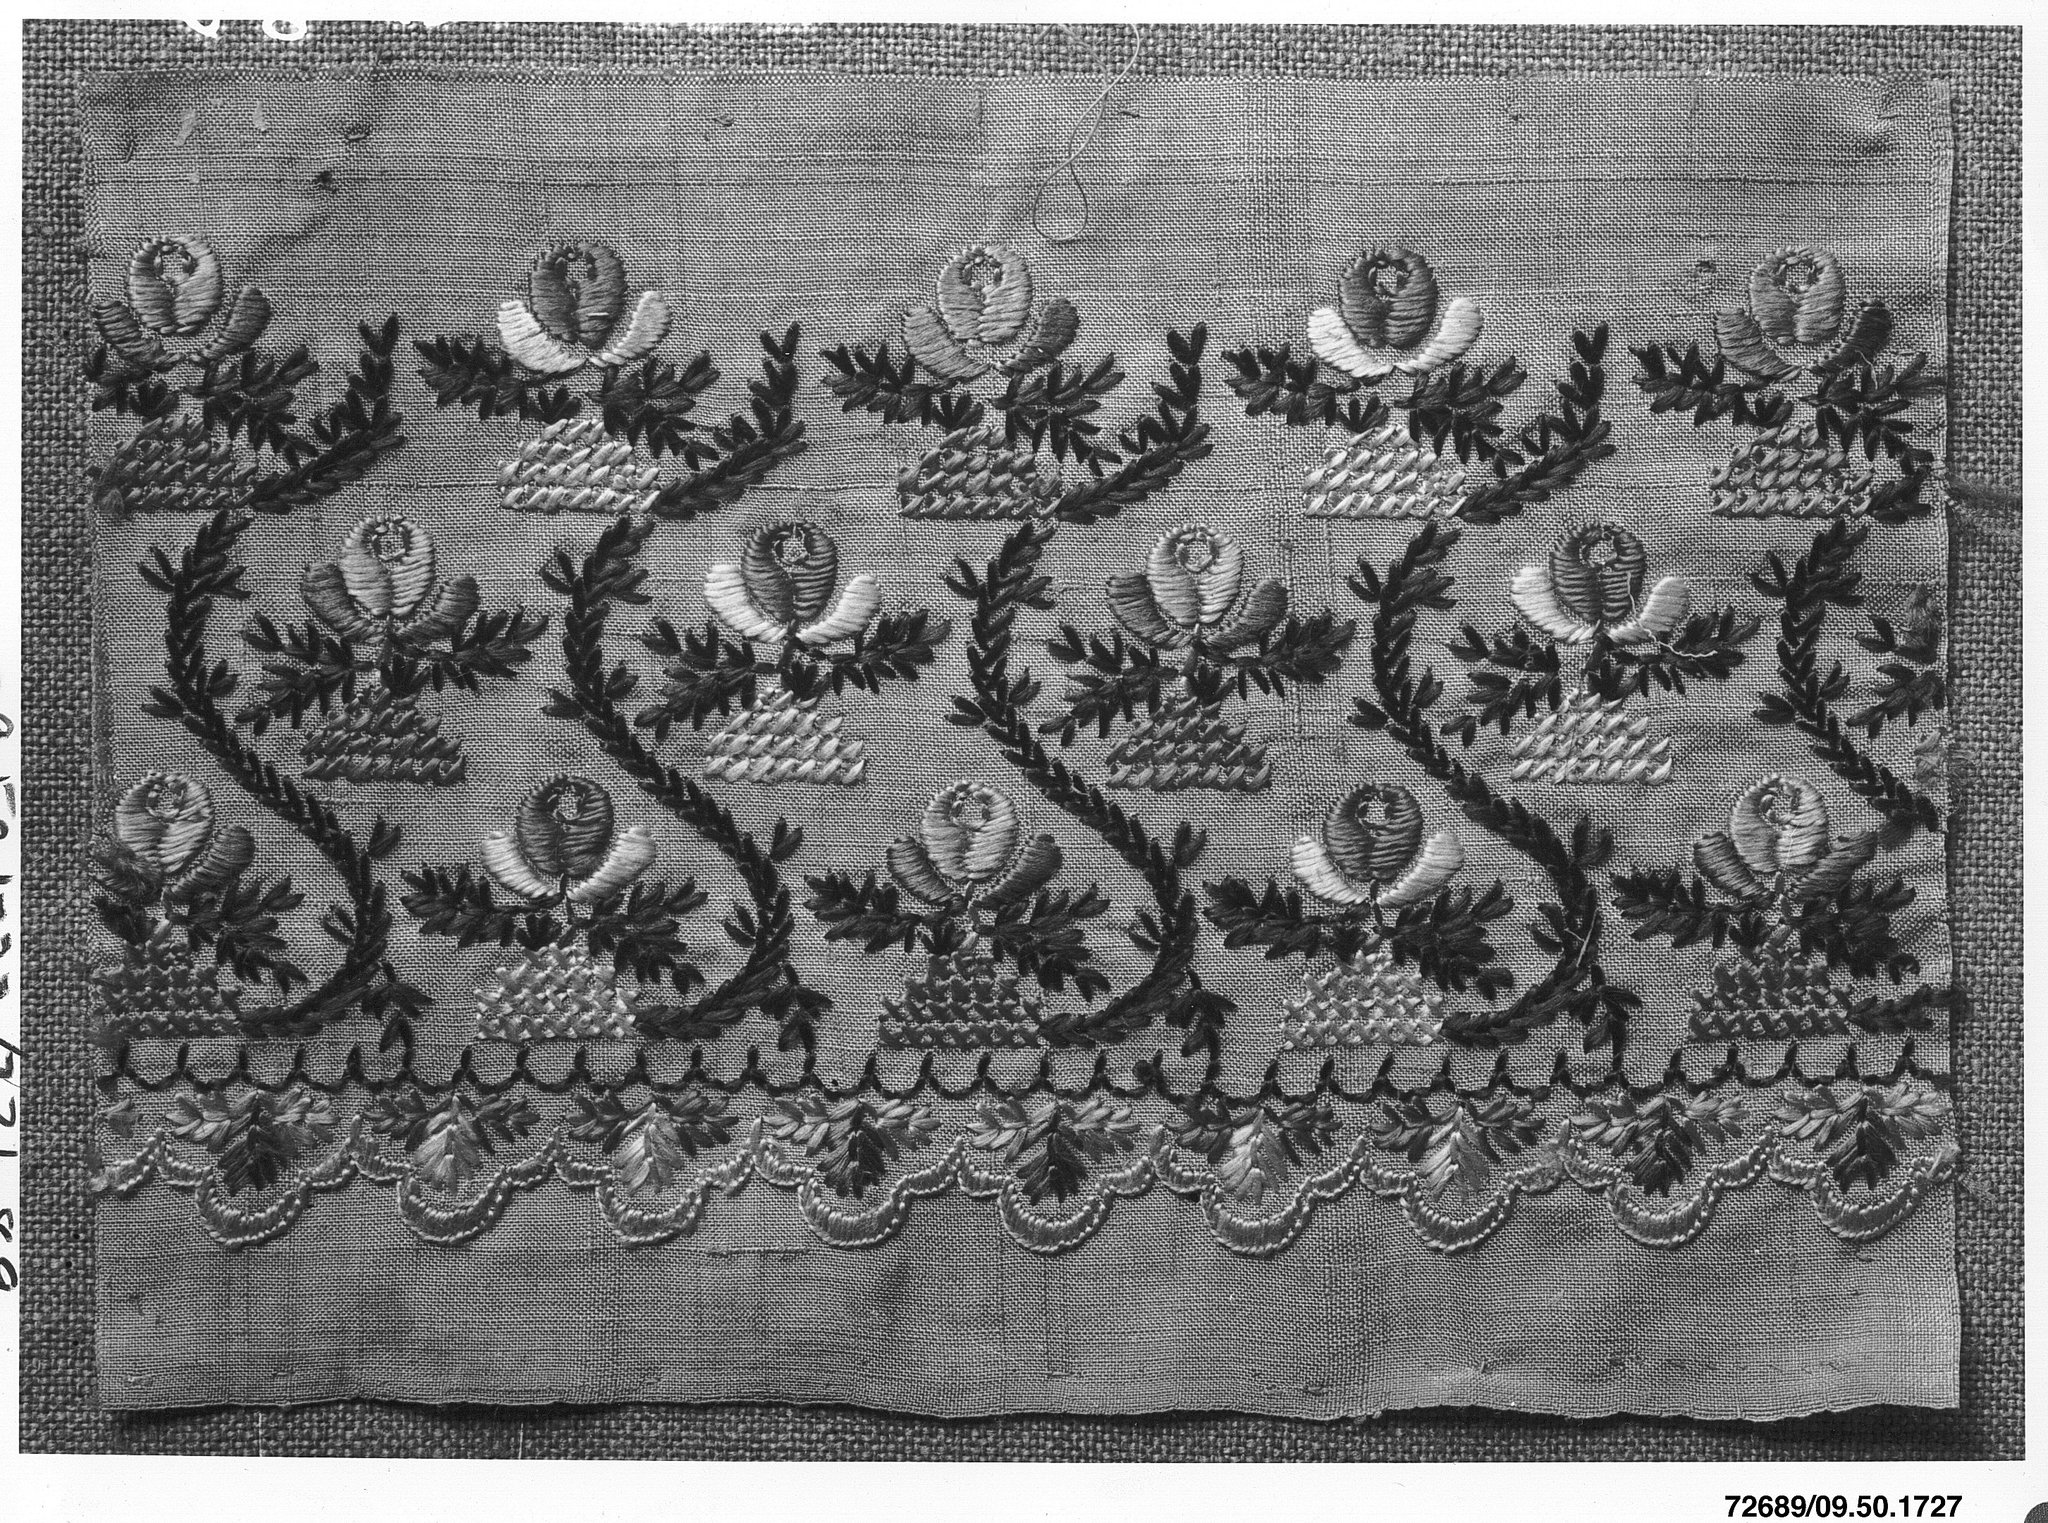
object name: fragment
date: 1801-1900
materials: silk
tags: leaves